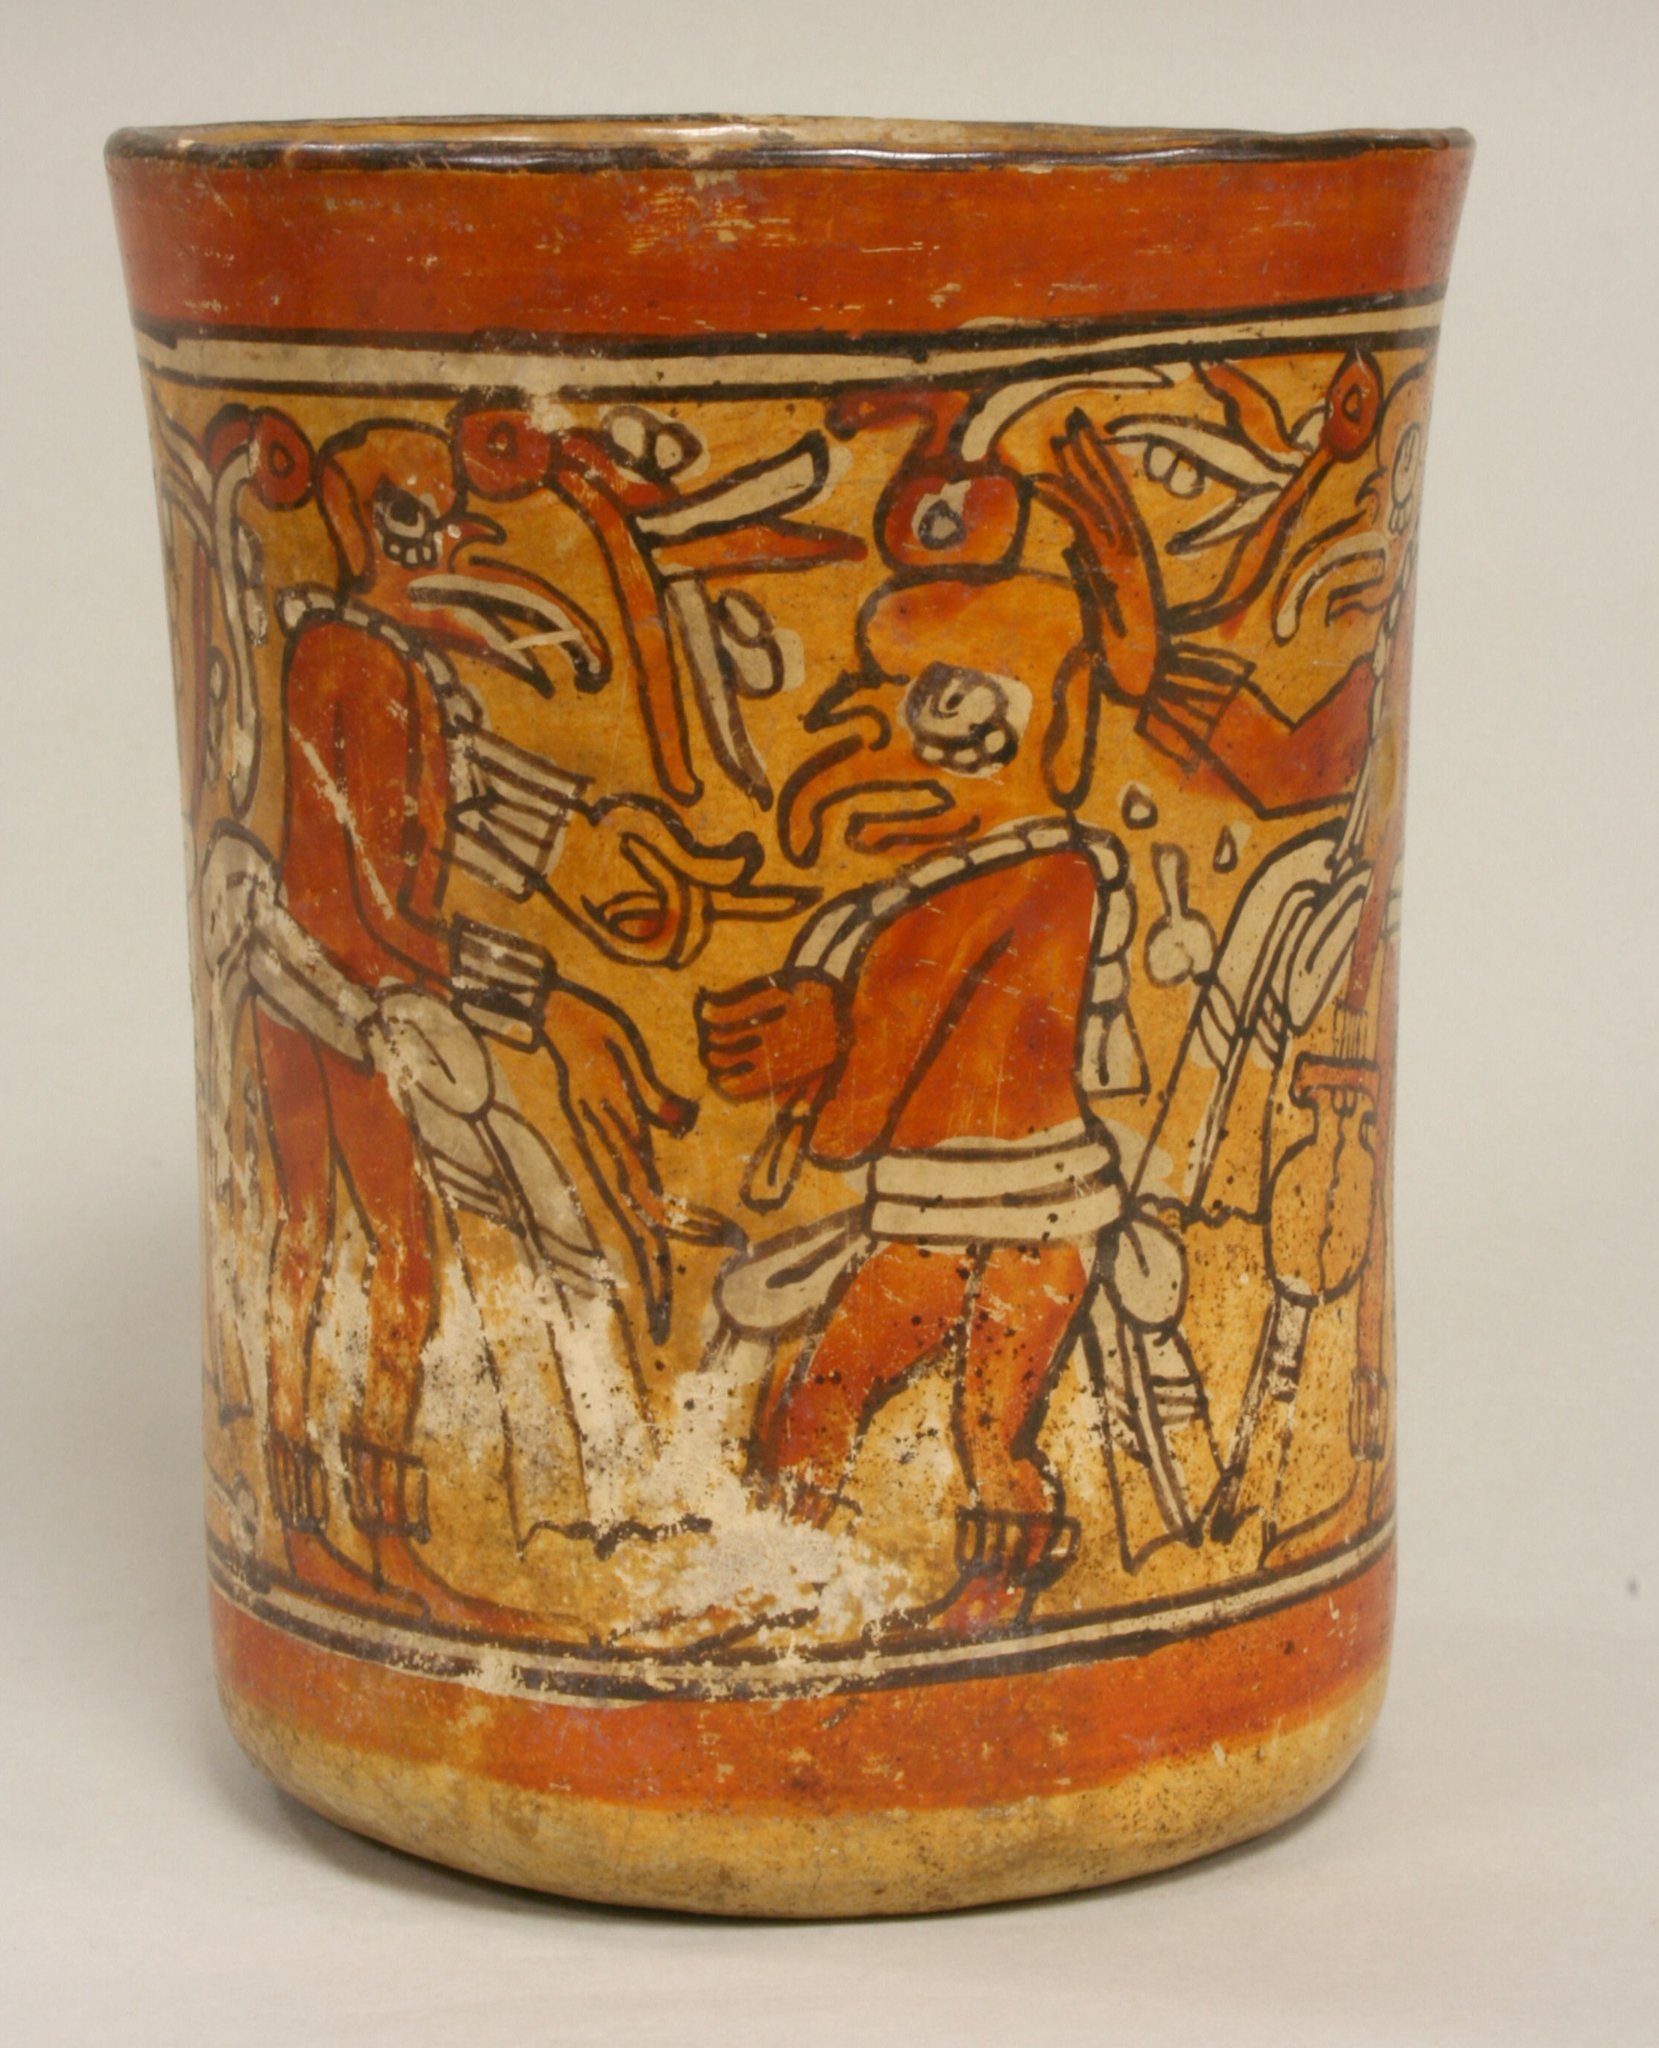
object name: vessel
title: Vessel with Deity Figures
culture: maya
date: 601-800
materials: ceramic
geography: guatemala or mexico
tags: deities